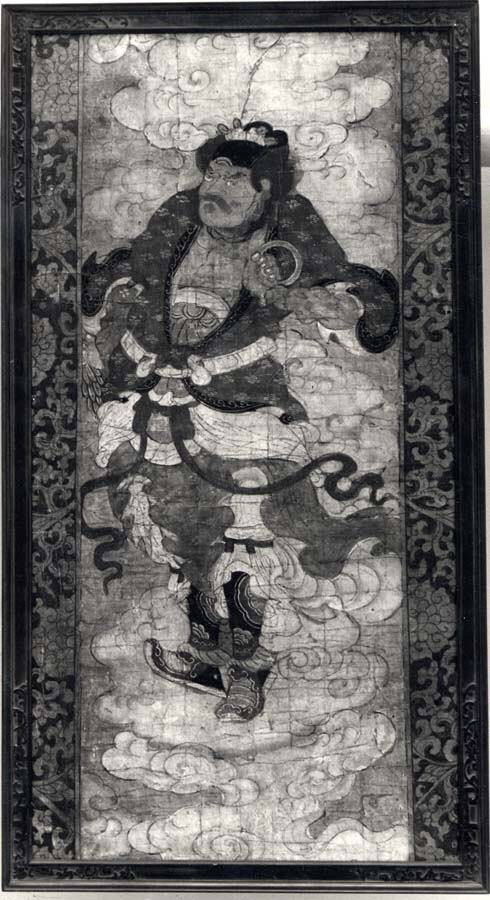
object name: painting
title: Vaisravana, Guardian of the North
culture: chinese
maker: unidentified artist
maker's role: artist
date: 1501-1600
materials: ink, paper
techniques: painting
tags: men